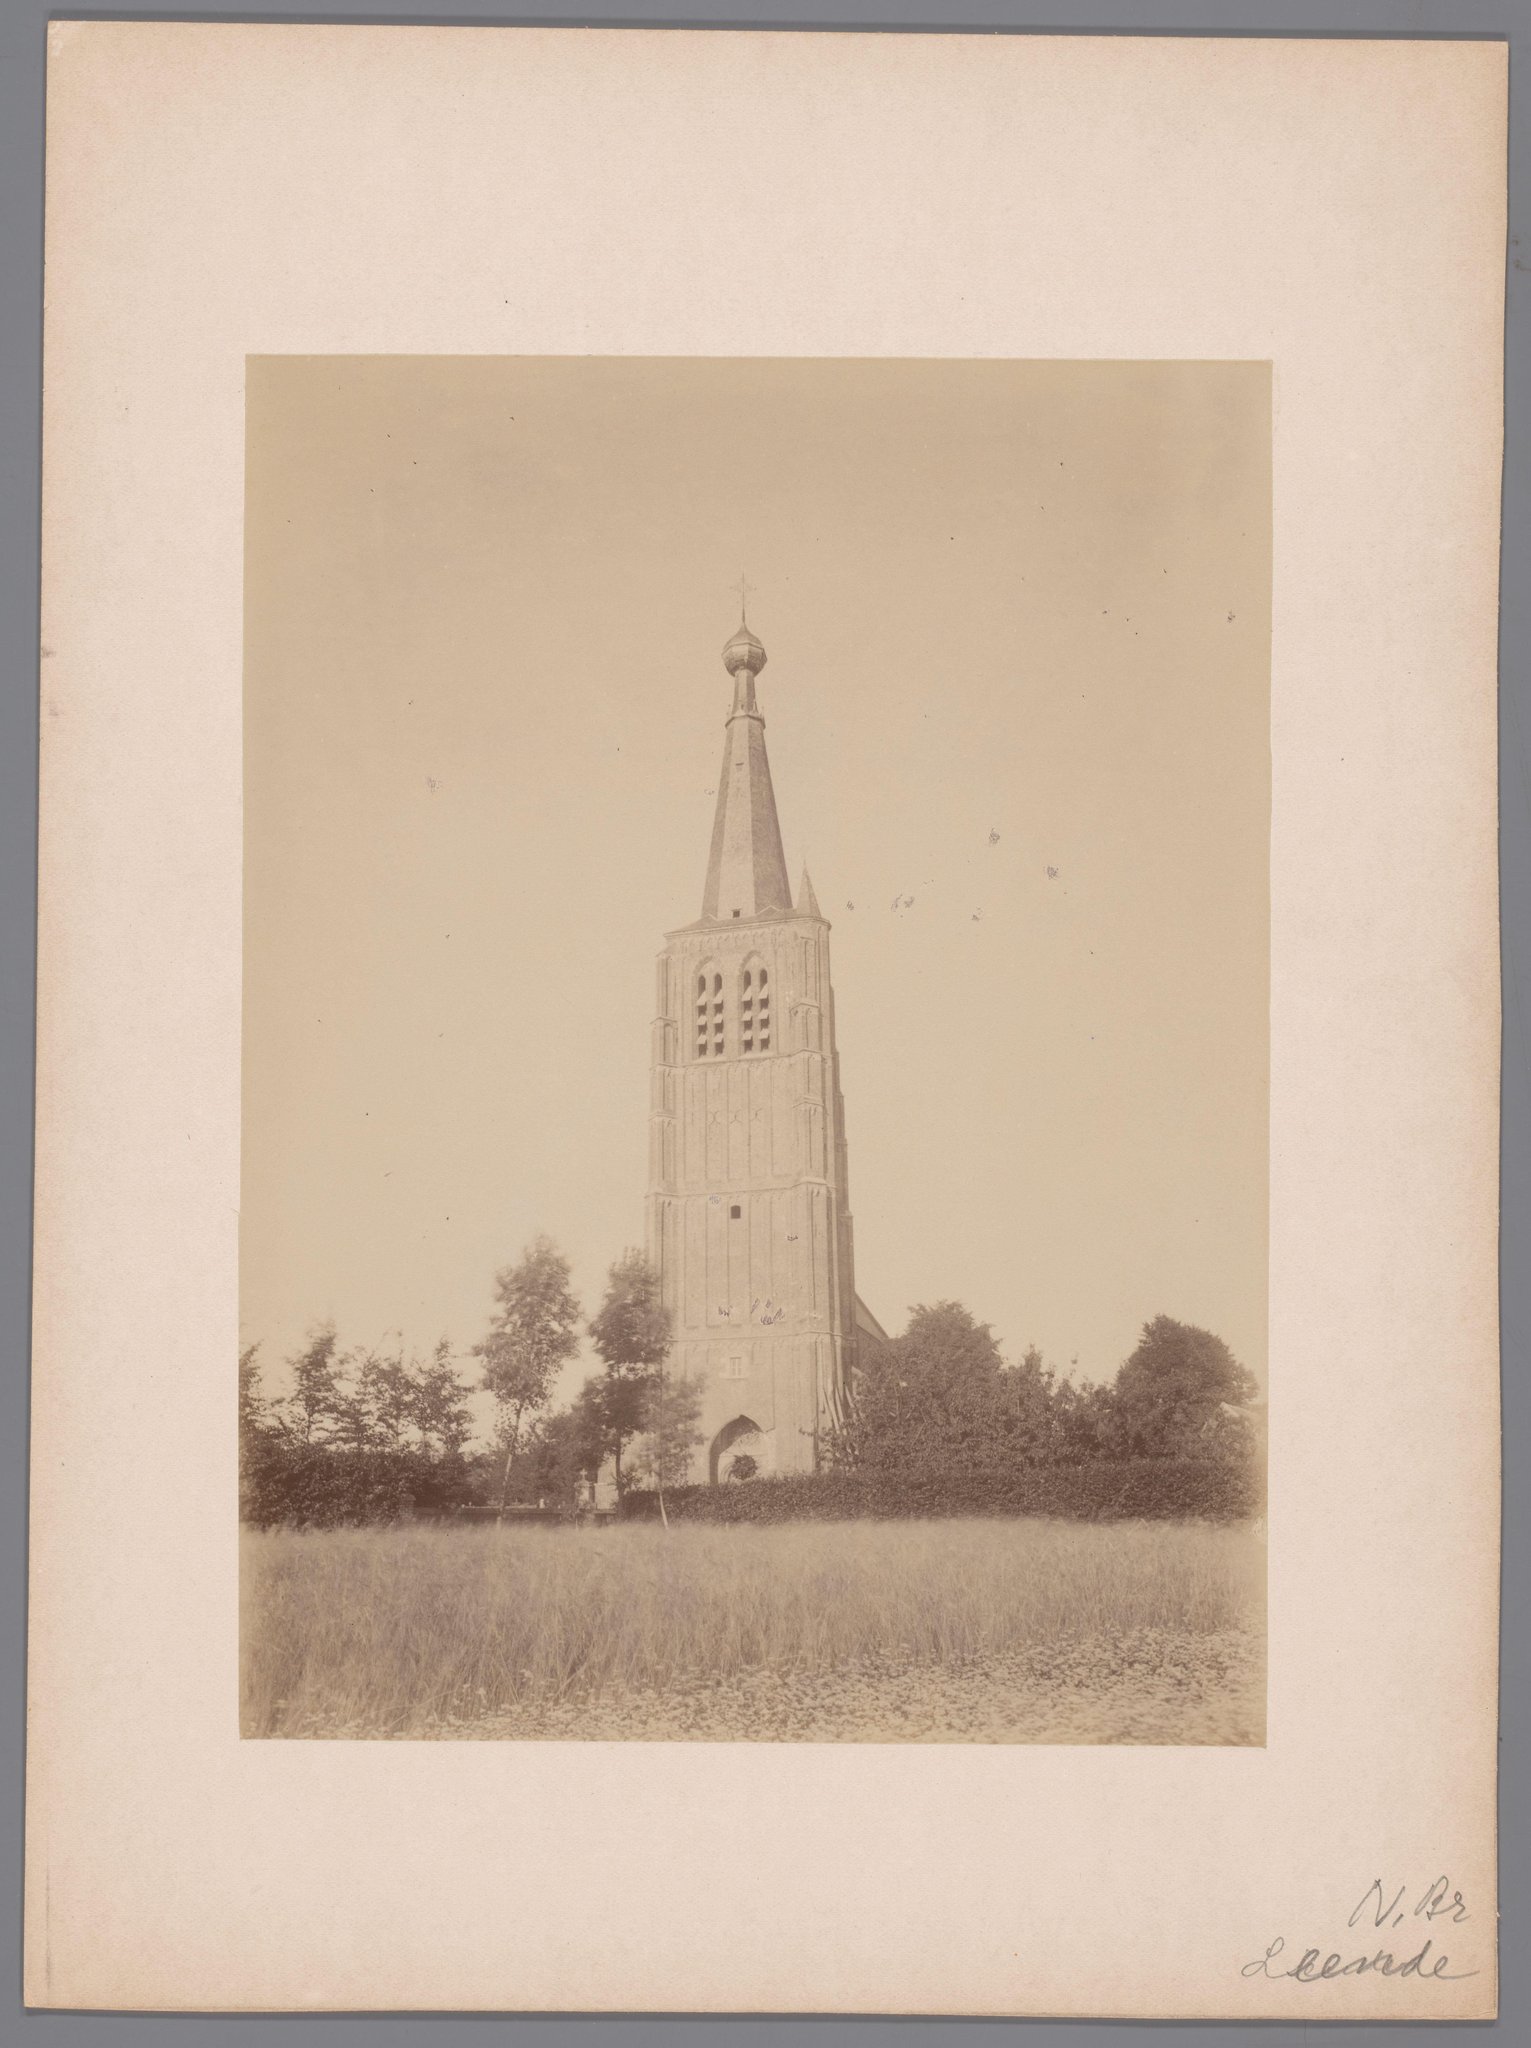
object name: photograph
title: Gezicht op de toren van de Sint-Petrus'-Bandenkerk te Leende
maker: anoniem (monumentenzorg)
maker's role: fotograaf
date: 1904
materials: cardboard, photographic support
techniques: albumen print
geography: leende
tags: meadow, pasture, parts of church exterior and annexes: tower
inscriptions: annotation: ‘N.Br./ Leende’, annotation: ‘Leende (N.B.)/ R.K. Kerk/ Juli 1904’